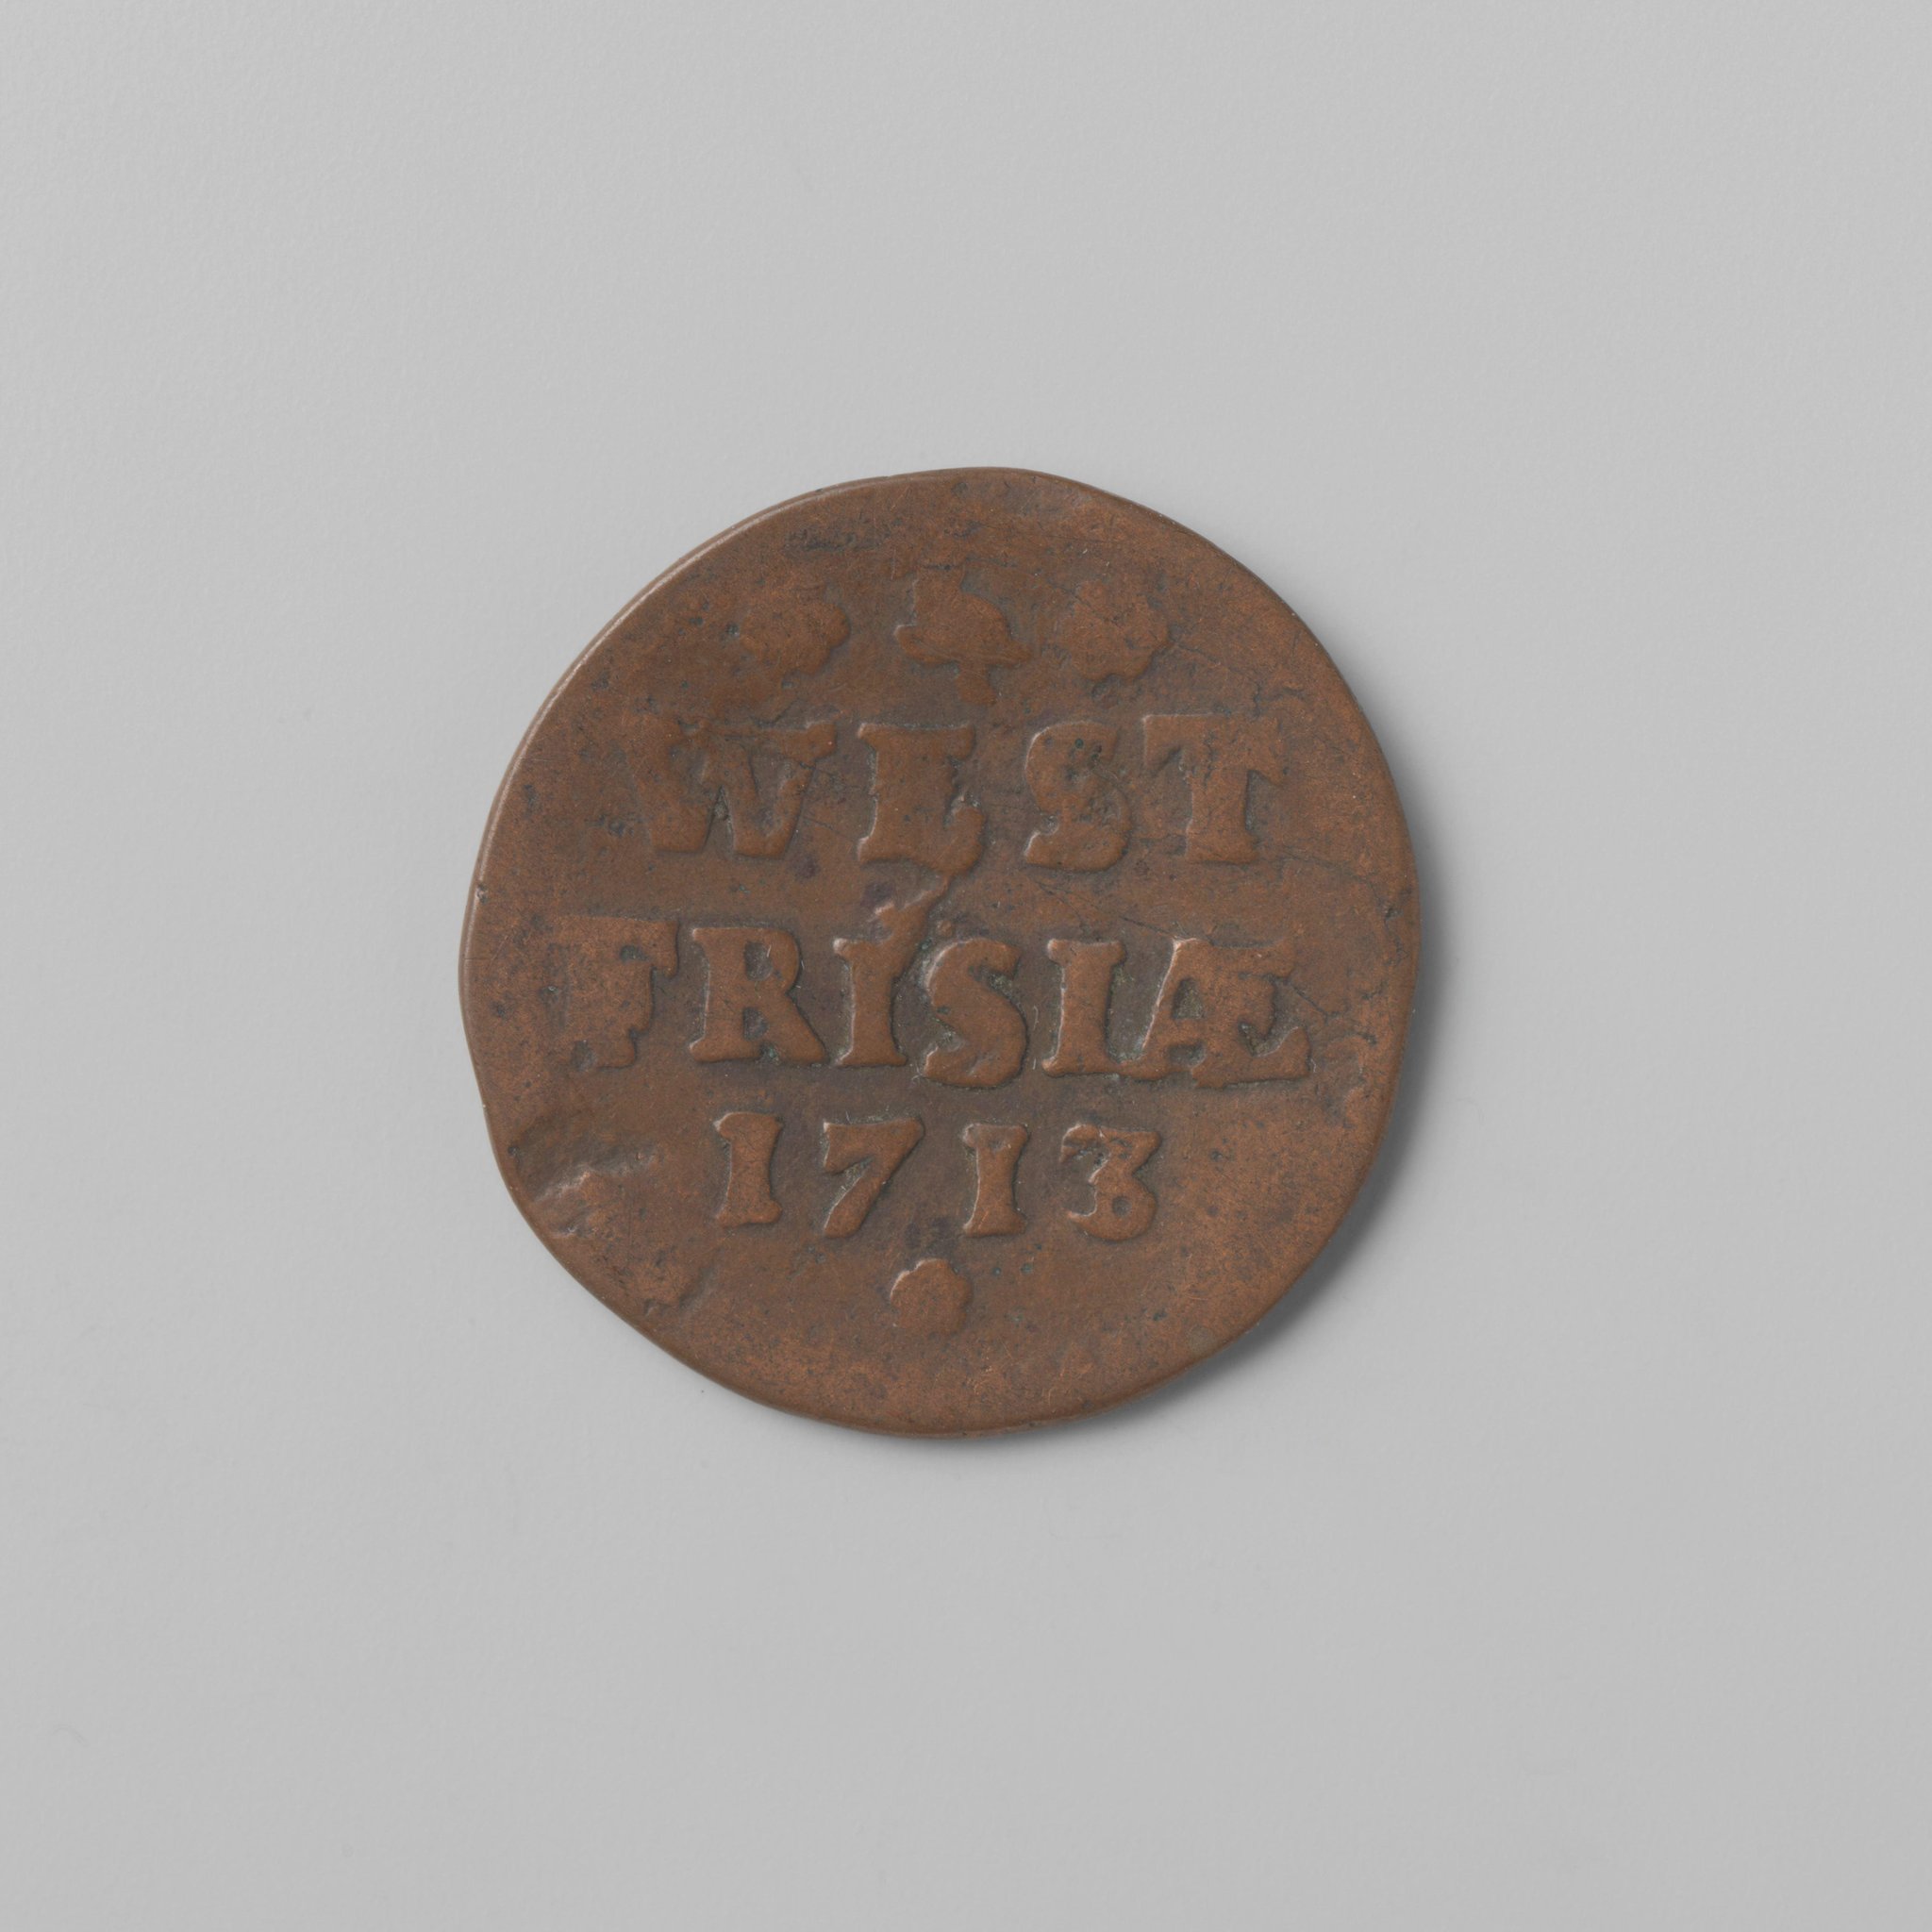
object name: coin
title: Westfriese duit, 1713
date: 1713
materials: copper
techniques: striking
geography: west frisia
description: Koperen munt. Voorzijde: gekroond wapenschild van West-Friesland met lauwertakken. Keerzijde: opschrift in twee regels. Daarboven muntmeesterteken kraanvogel tussen twee rozetten. Daaronder jaartal, waaronder rozet.